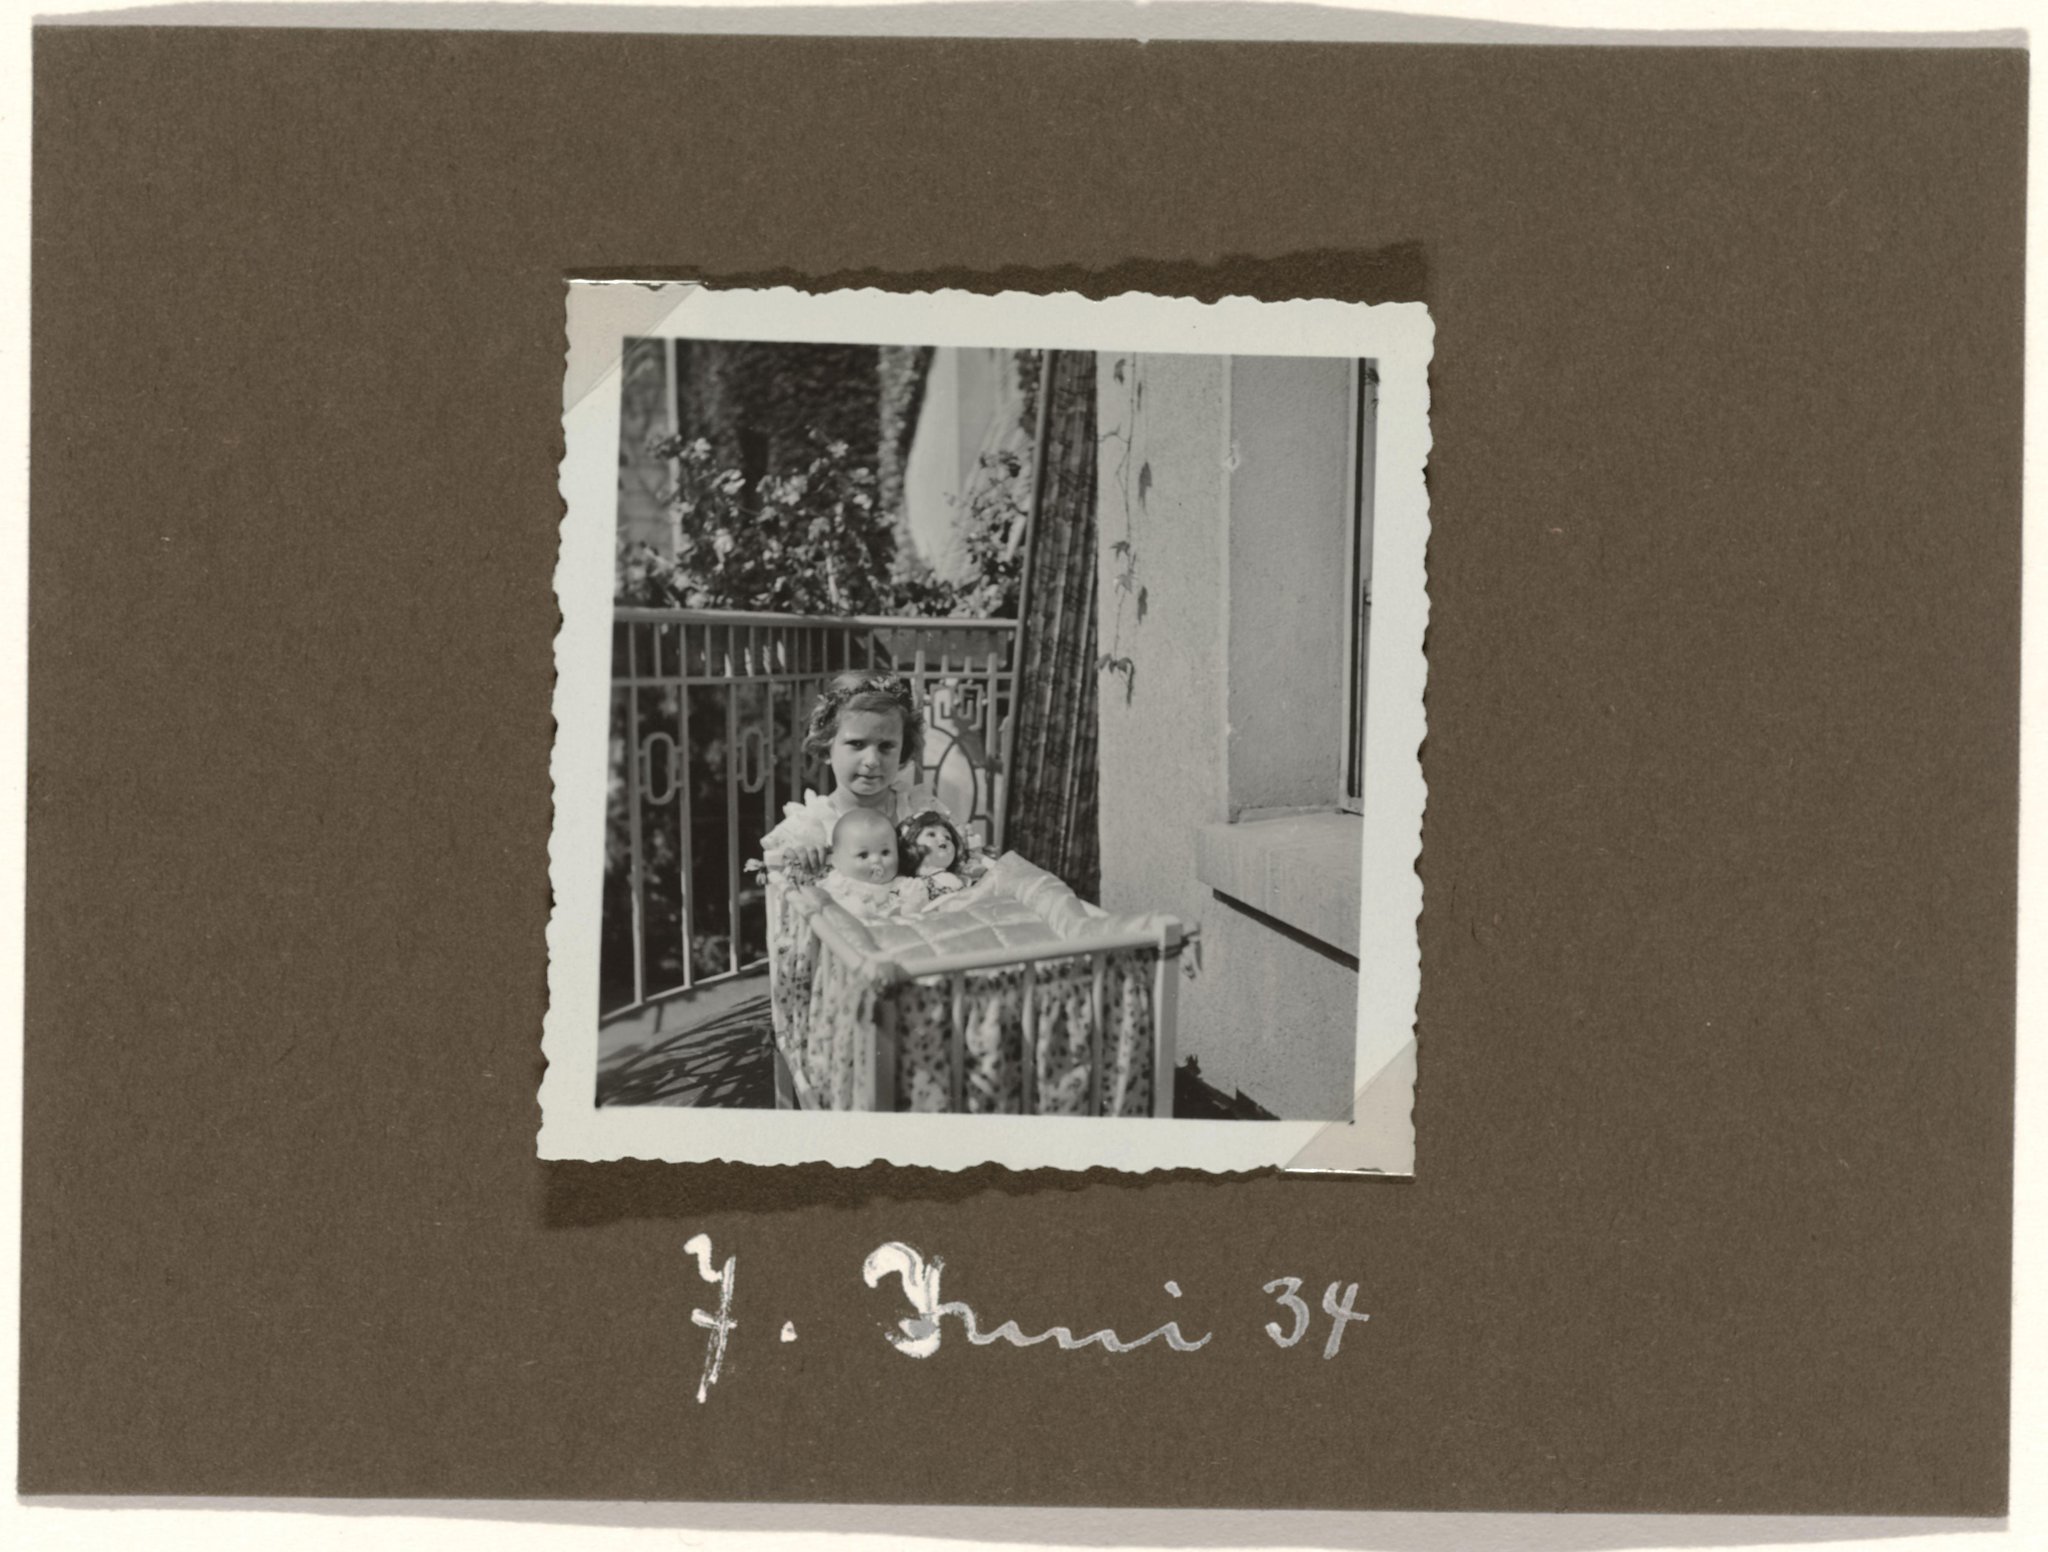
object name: photograph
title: Isabel op het balkon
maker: Anonymous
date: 1934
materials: photographic support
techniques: gelatin silver print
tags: leiden, isabel wachenheimer-elon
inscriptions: date